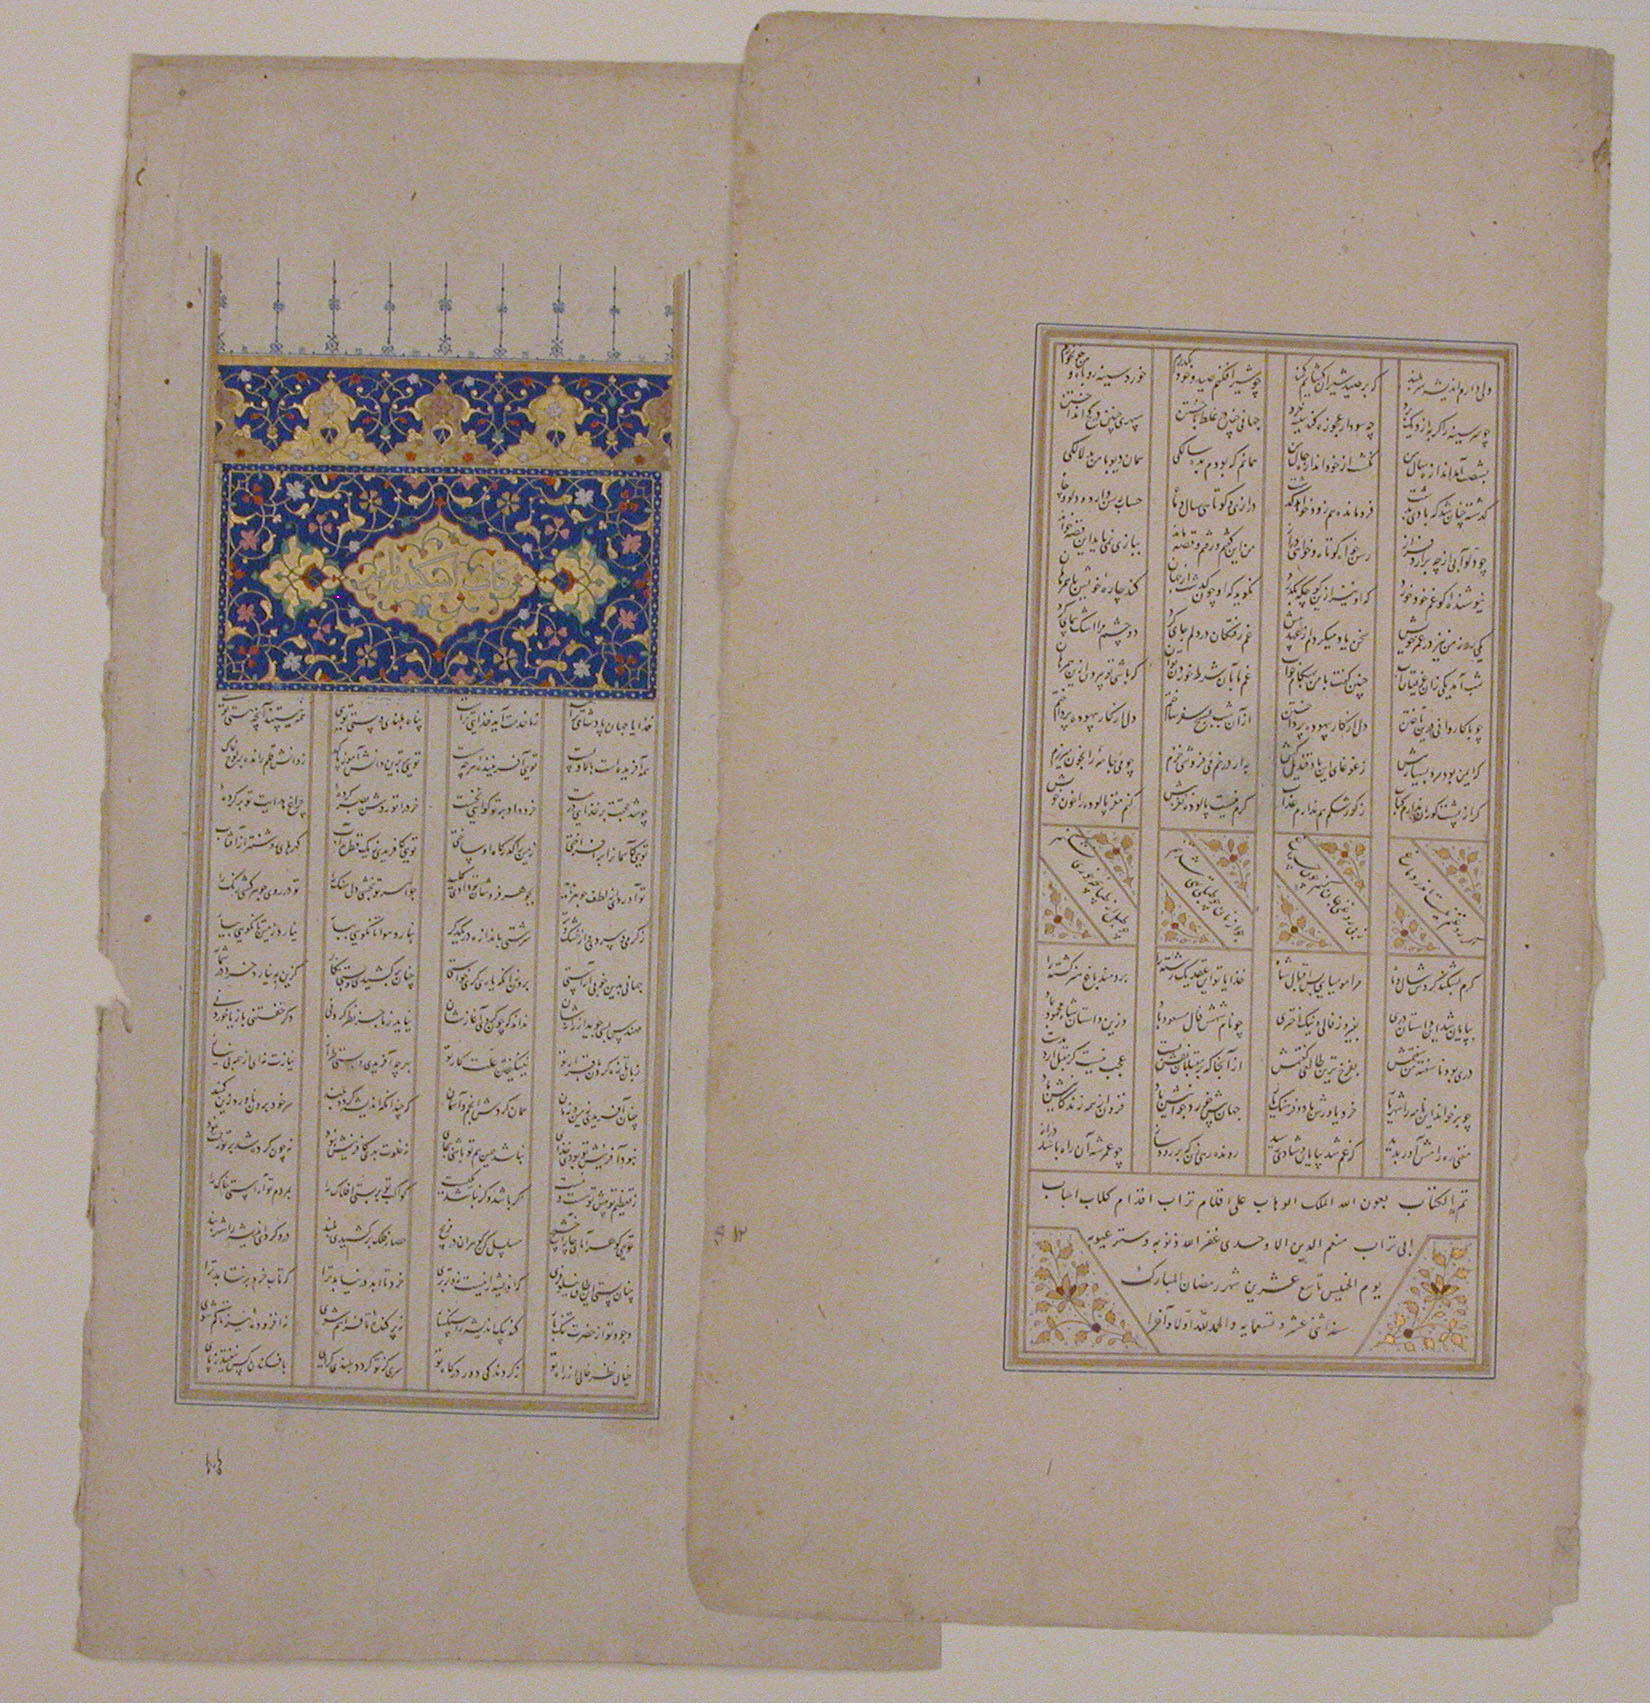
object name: folio from a non illustrated manuscript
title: Colophon Page from Iskandarnama Manuscript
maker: abu turab mun'im al-din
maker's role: calligrapher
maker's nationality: iranian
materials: gold, ink, paper, watercolor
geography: iran